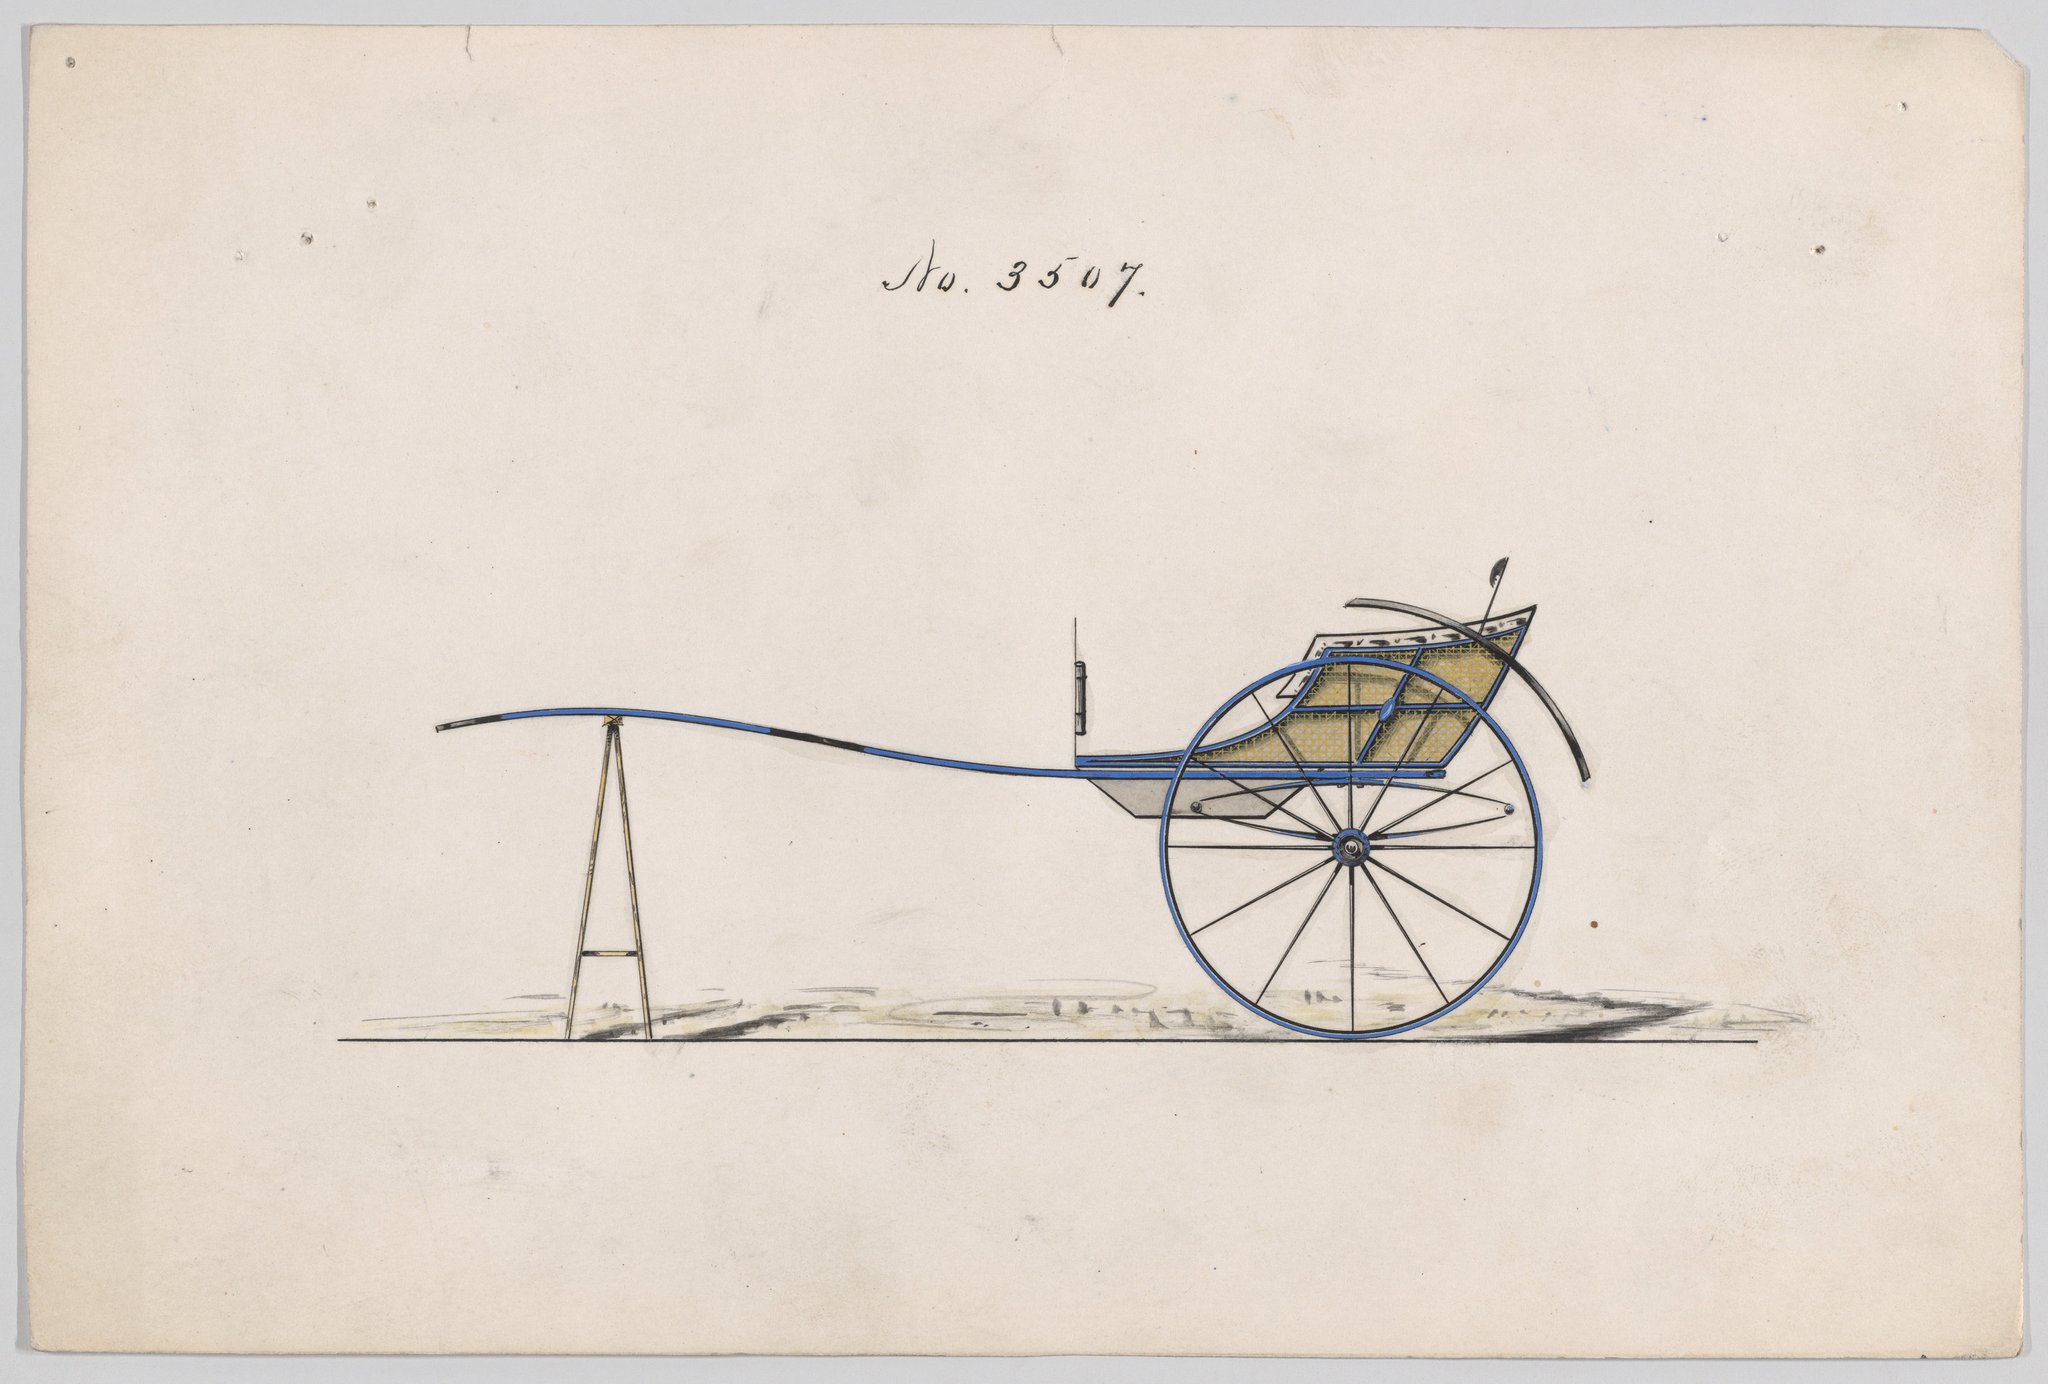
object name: drawing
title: Gig #3507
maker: brewster & co.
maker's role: manufacturer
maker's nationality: american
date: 1879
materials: gouache, gum arabic, ink, watercolor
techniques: pen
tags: carriages